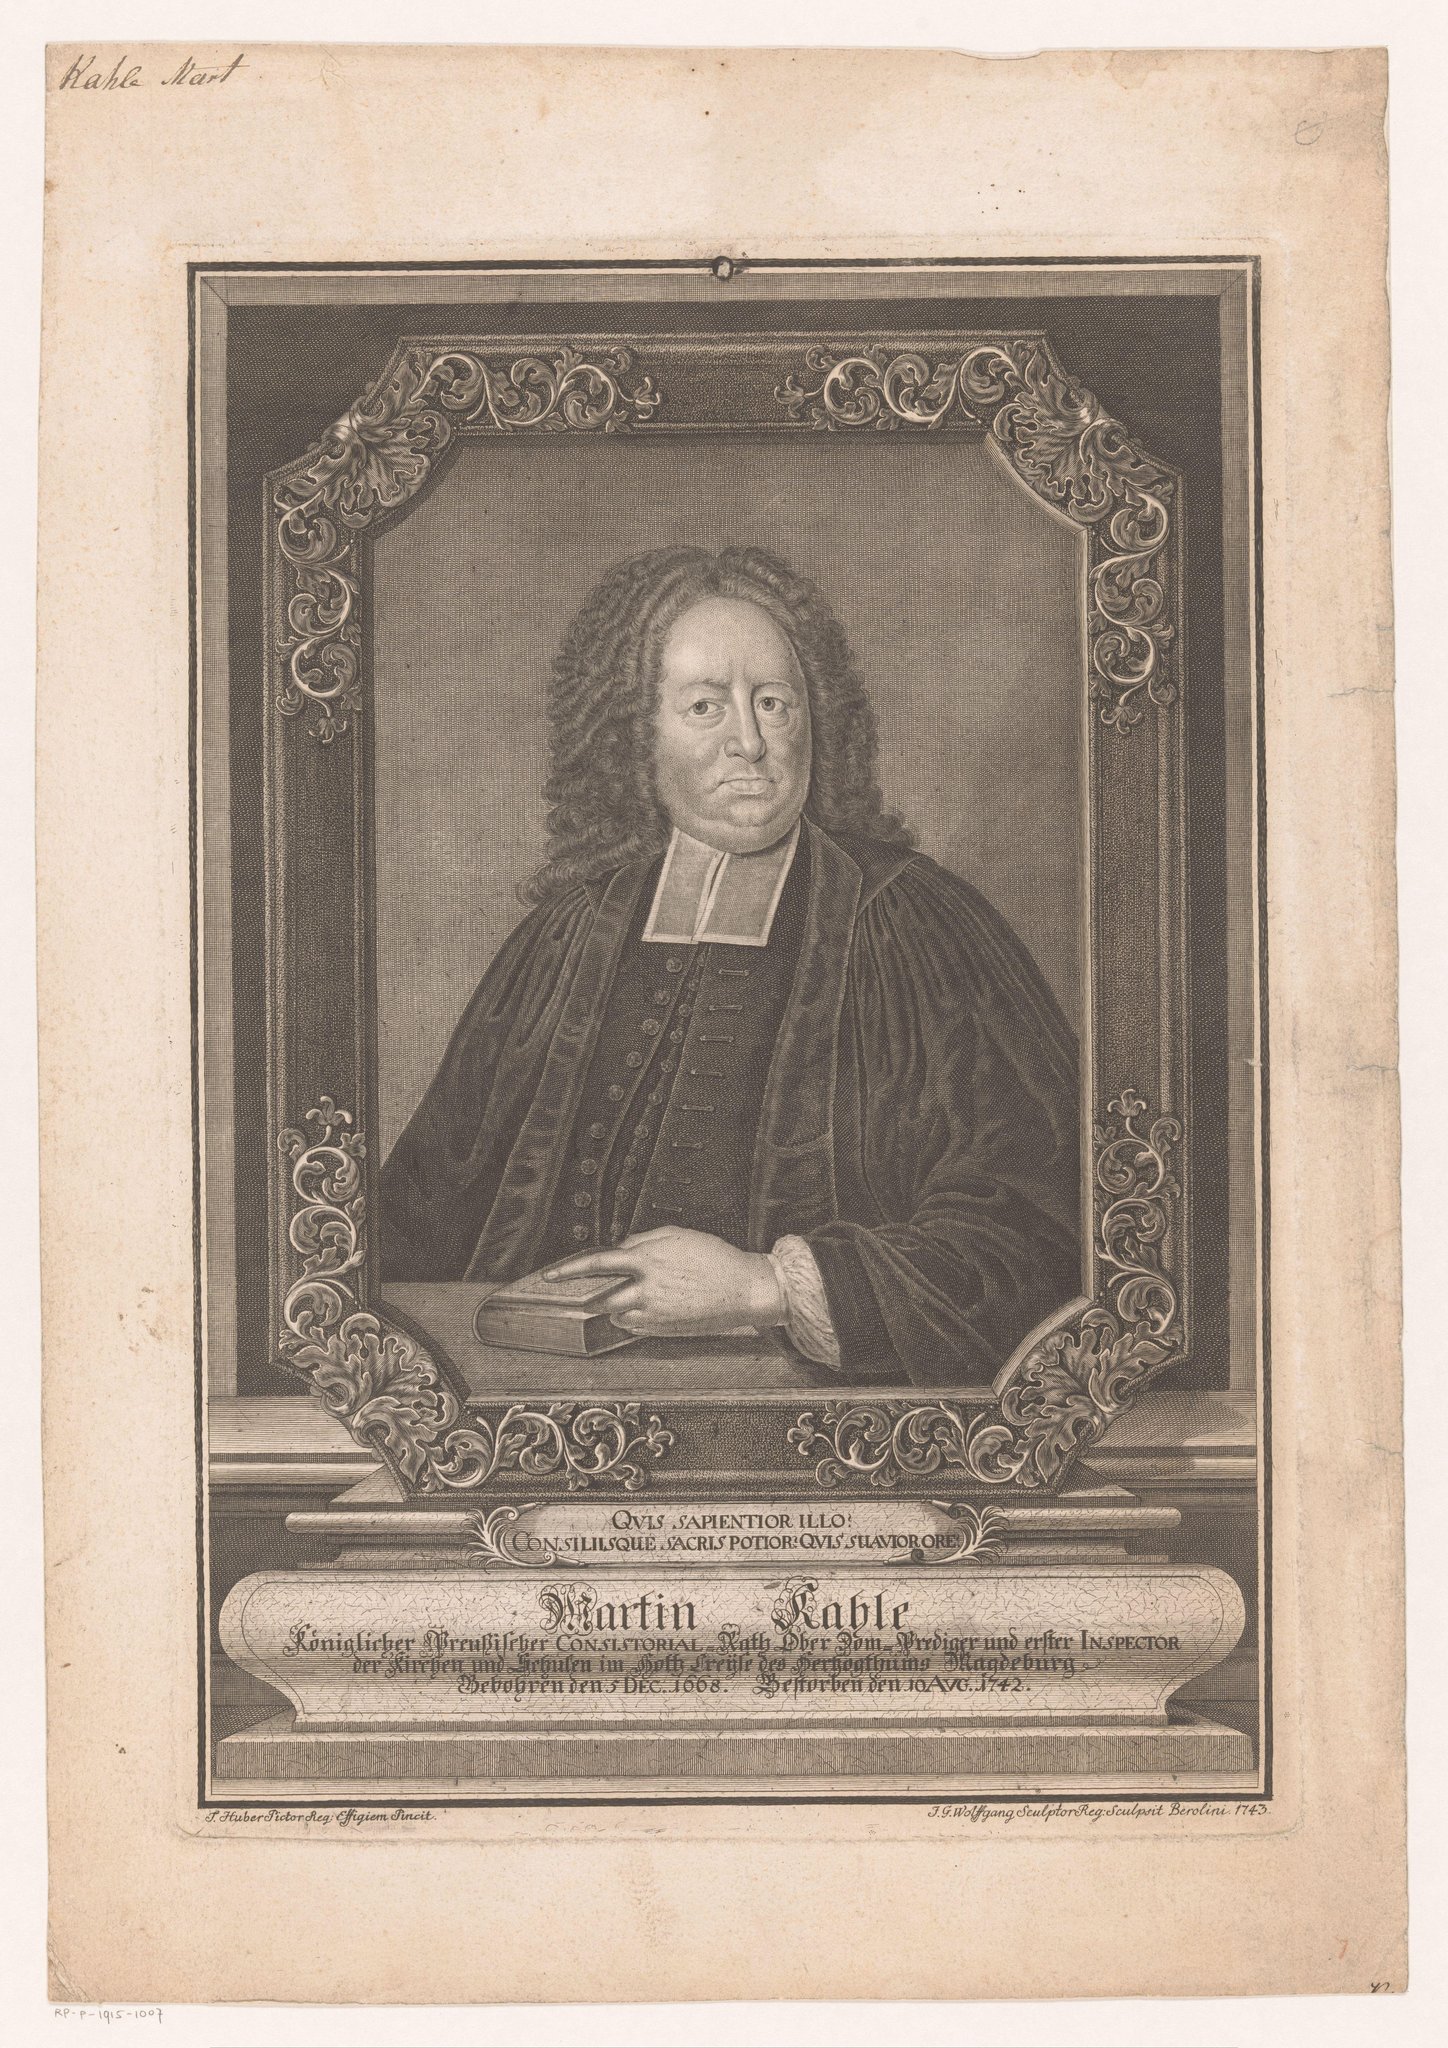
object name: print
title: Portret van Martin Kahle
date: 1743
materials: paper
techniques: engraving, etching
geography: berlin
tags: historical persons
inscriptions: collector's mark: Lugt 2228, inscription: ‘Kahle Mart’